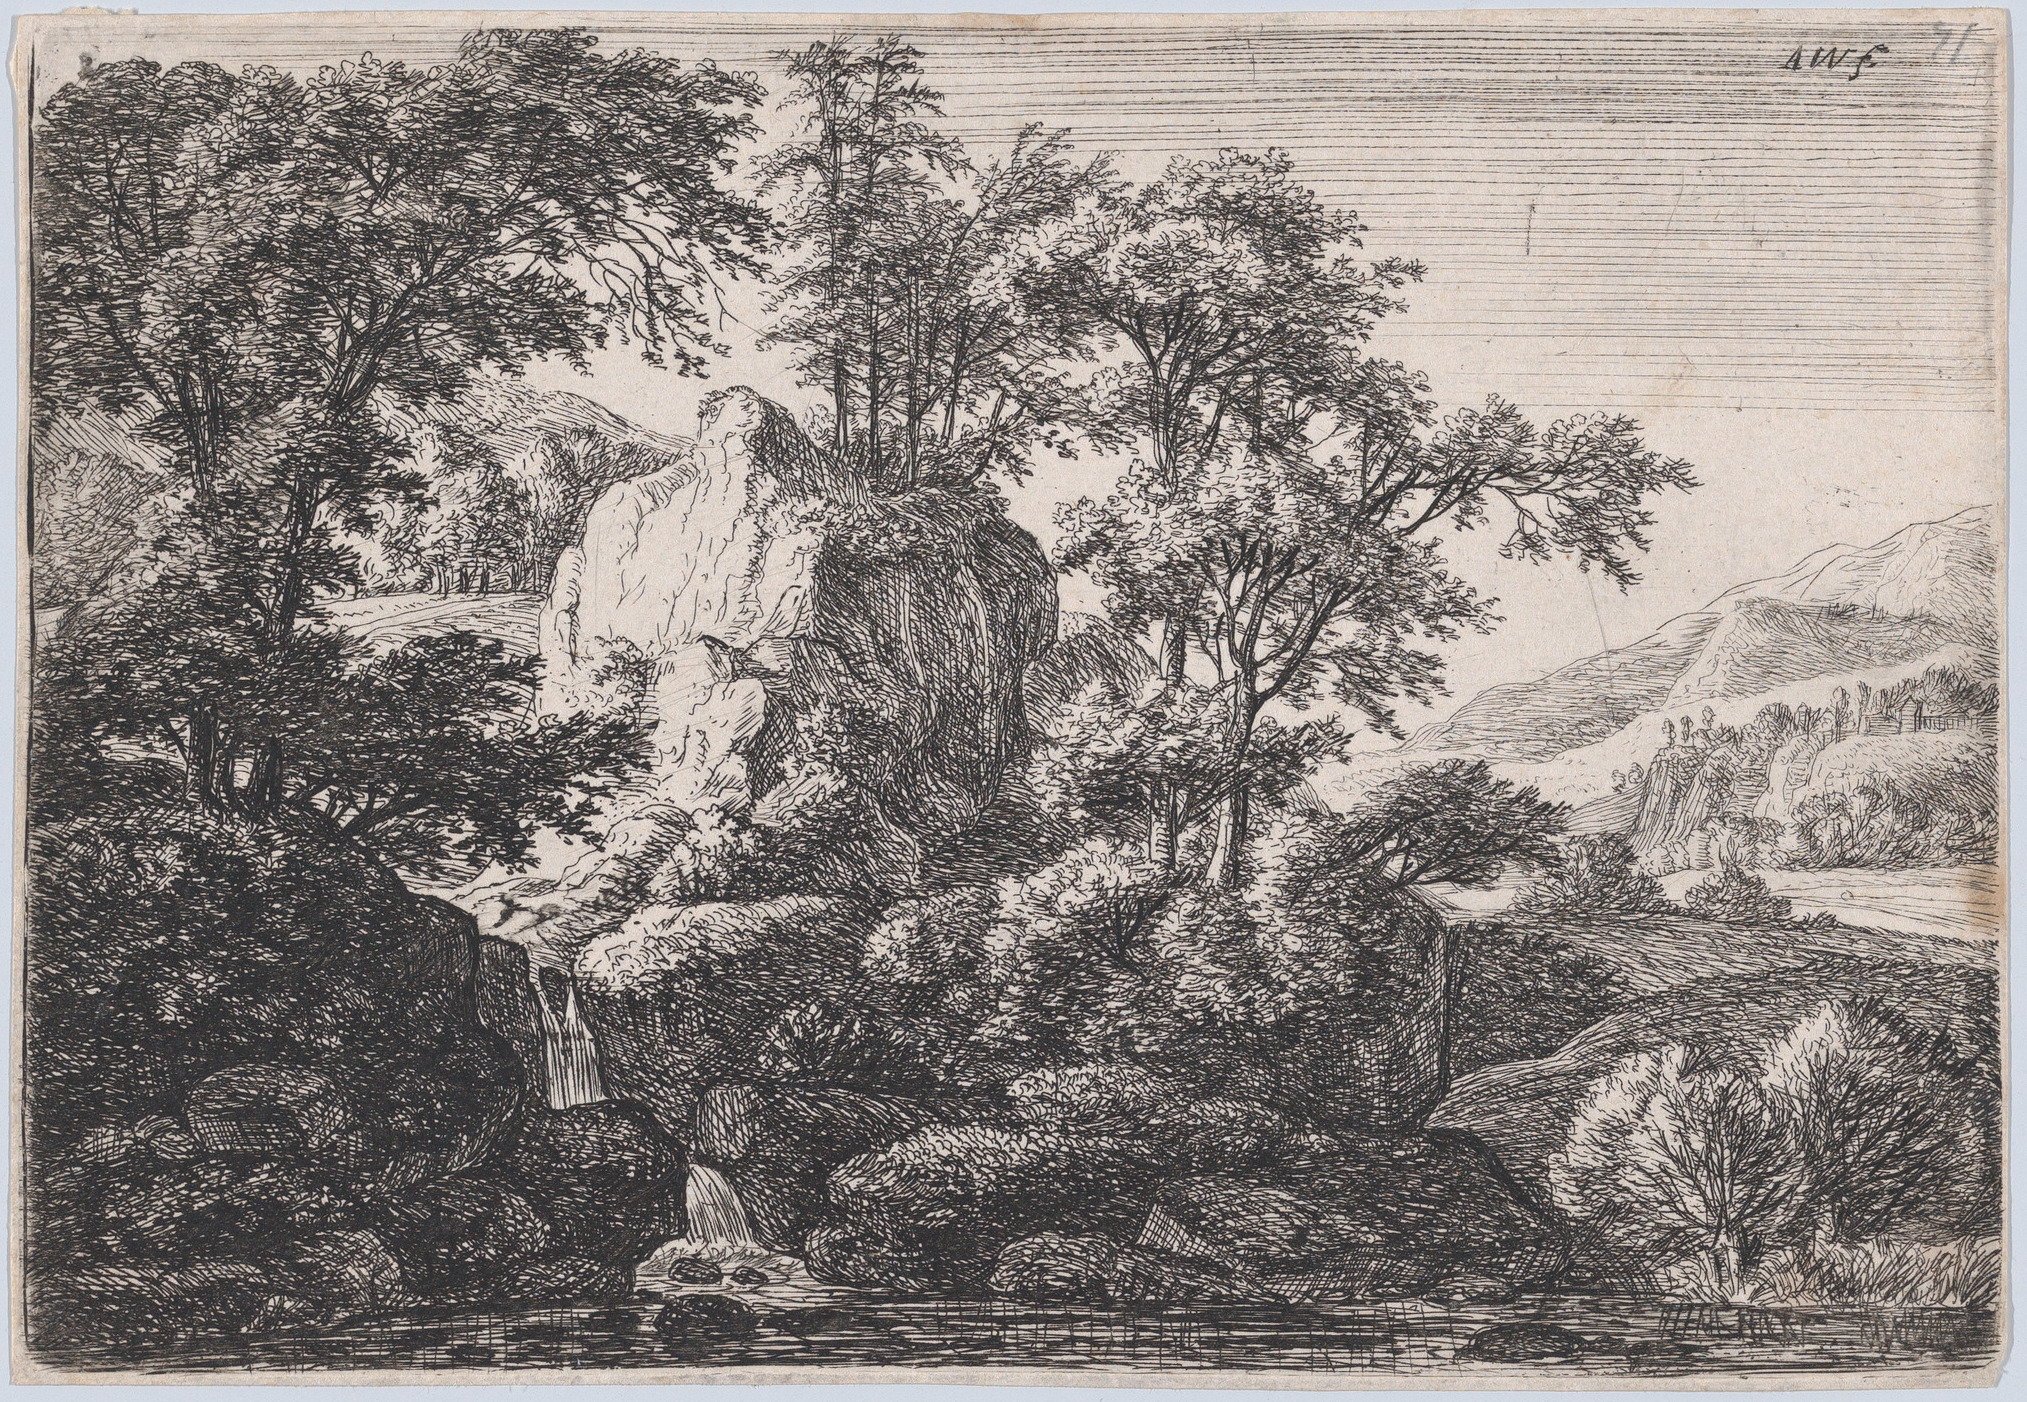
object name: print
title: The Double Cascade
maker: anthonie waterloo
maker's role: artist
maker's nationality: dutch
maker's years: 1609-1690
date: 1601-1700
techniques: etching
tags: waterfalls,hills,trees